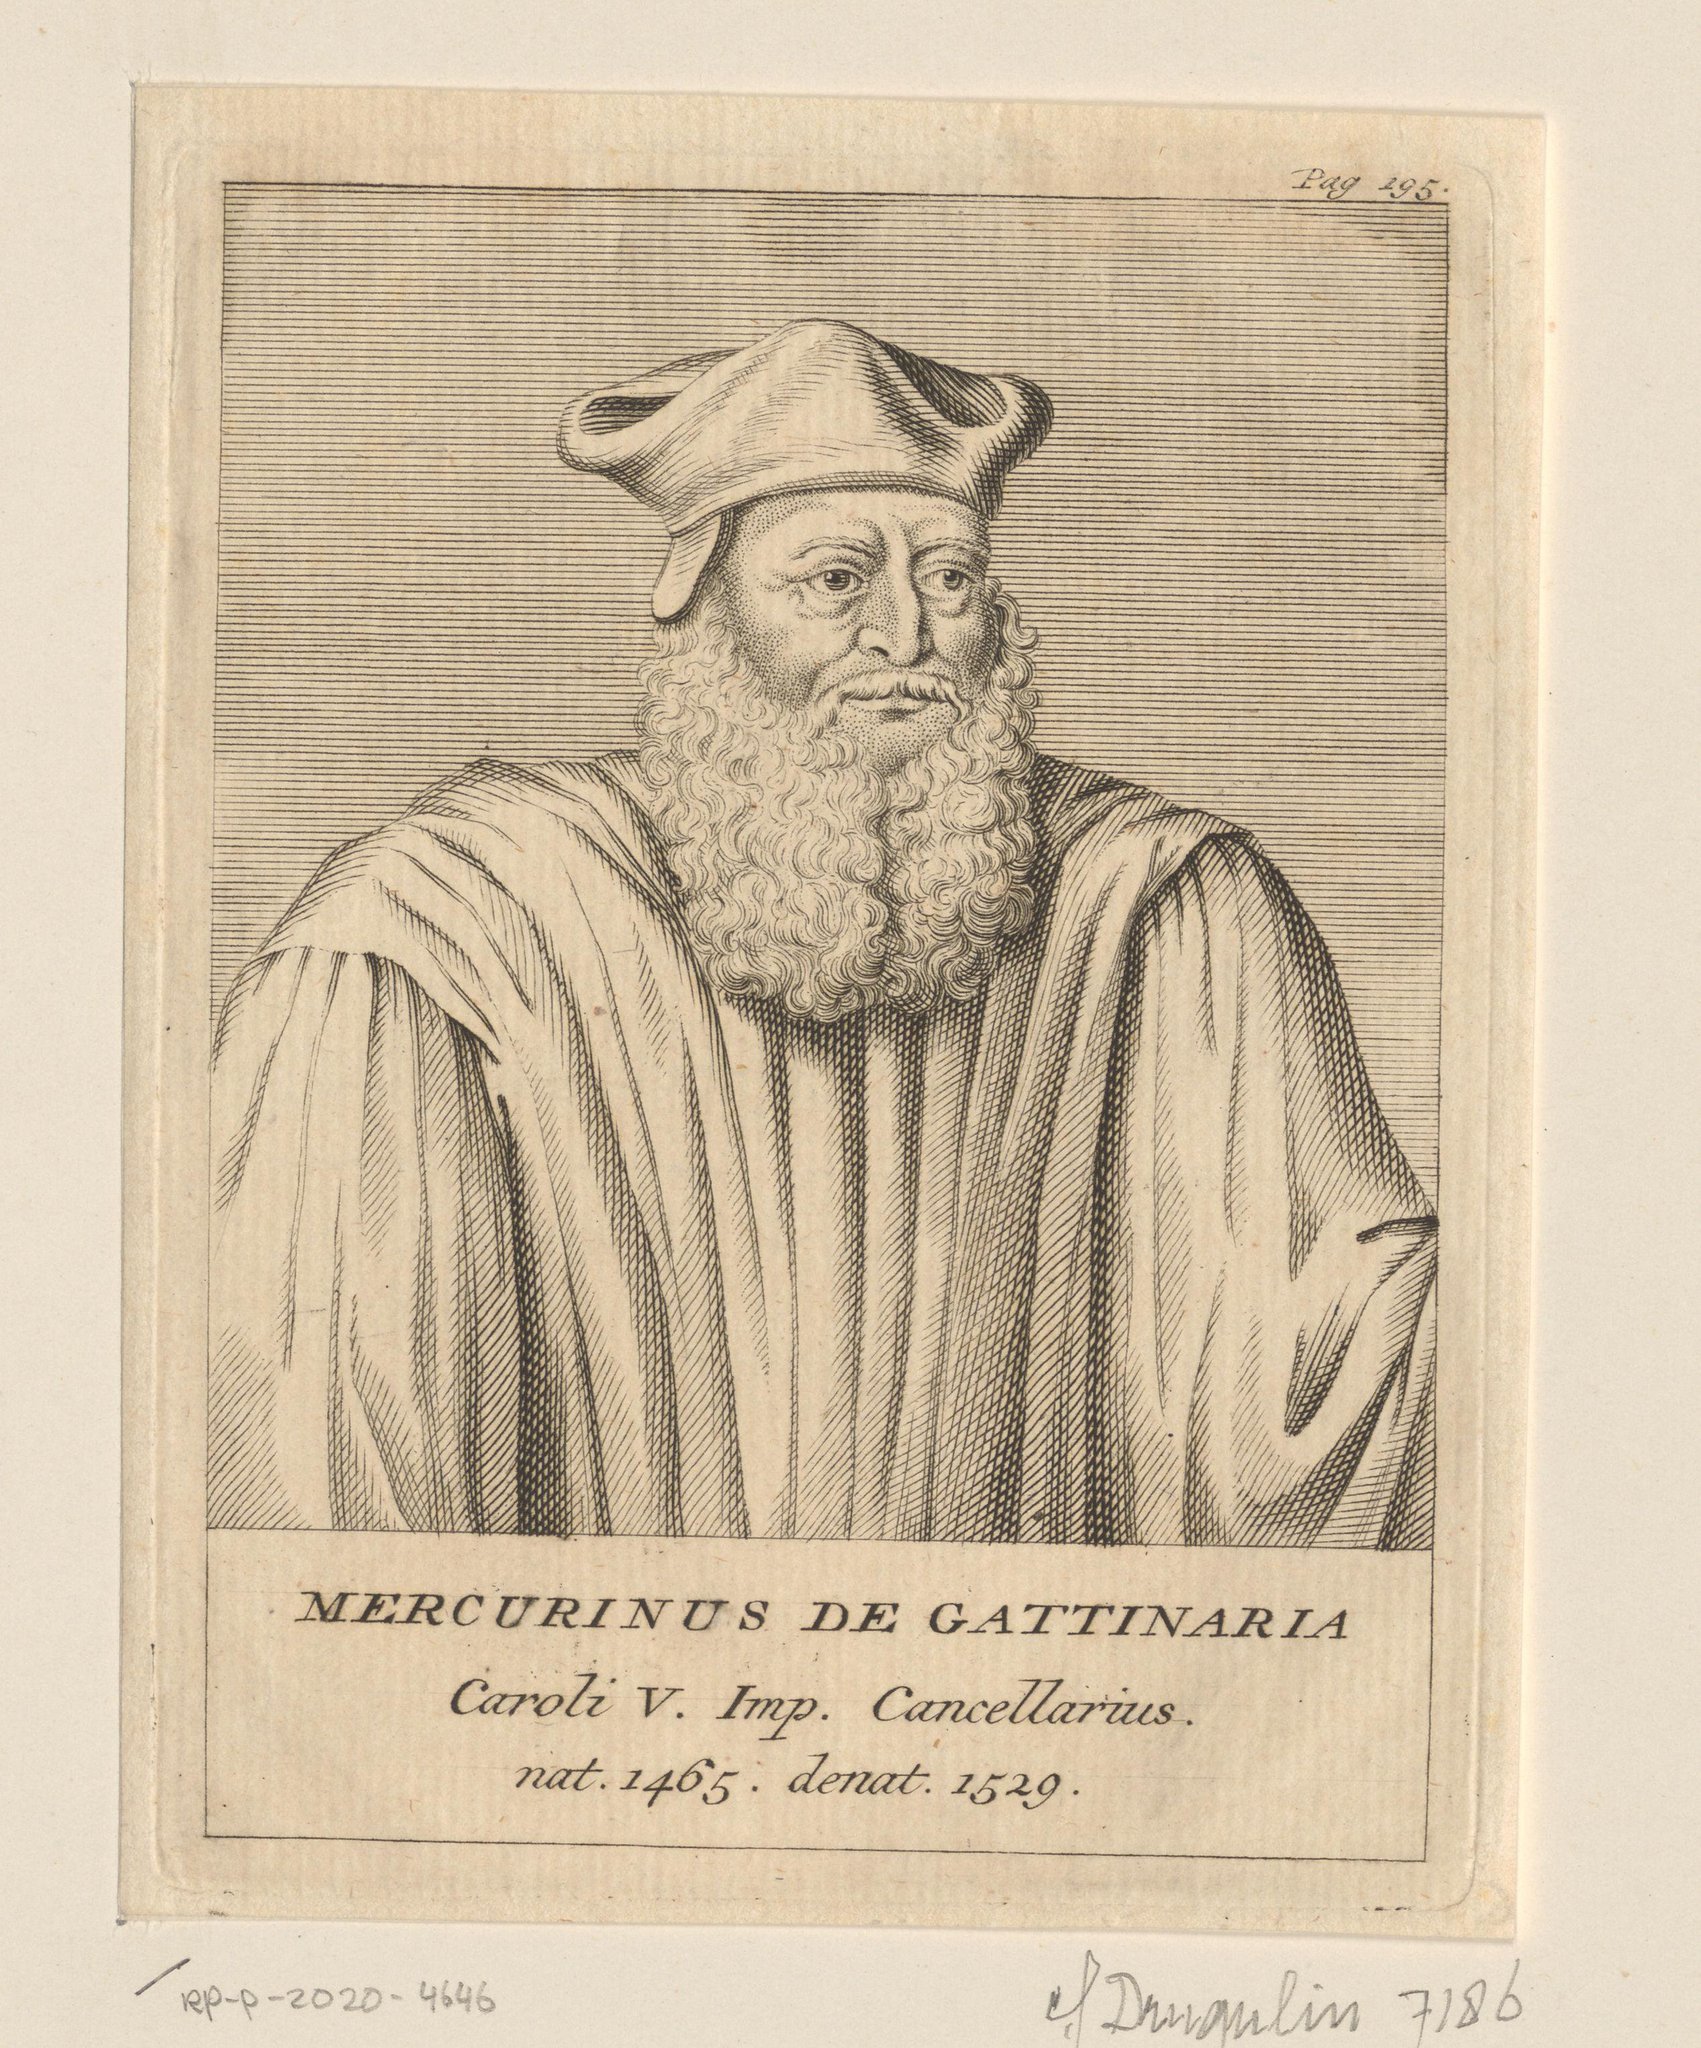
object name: print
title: Portret van Mercurius Arboro de Gattinara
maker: françois van bleyswijck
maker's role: draughtsman, print maker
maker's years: 1671-1746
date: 1681-1746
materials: paper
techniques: engraving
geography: leiden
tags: theologian, historical persons, politician, e.g. party leader